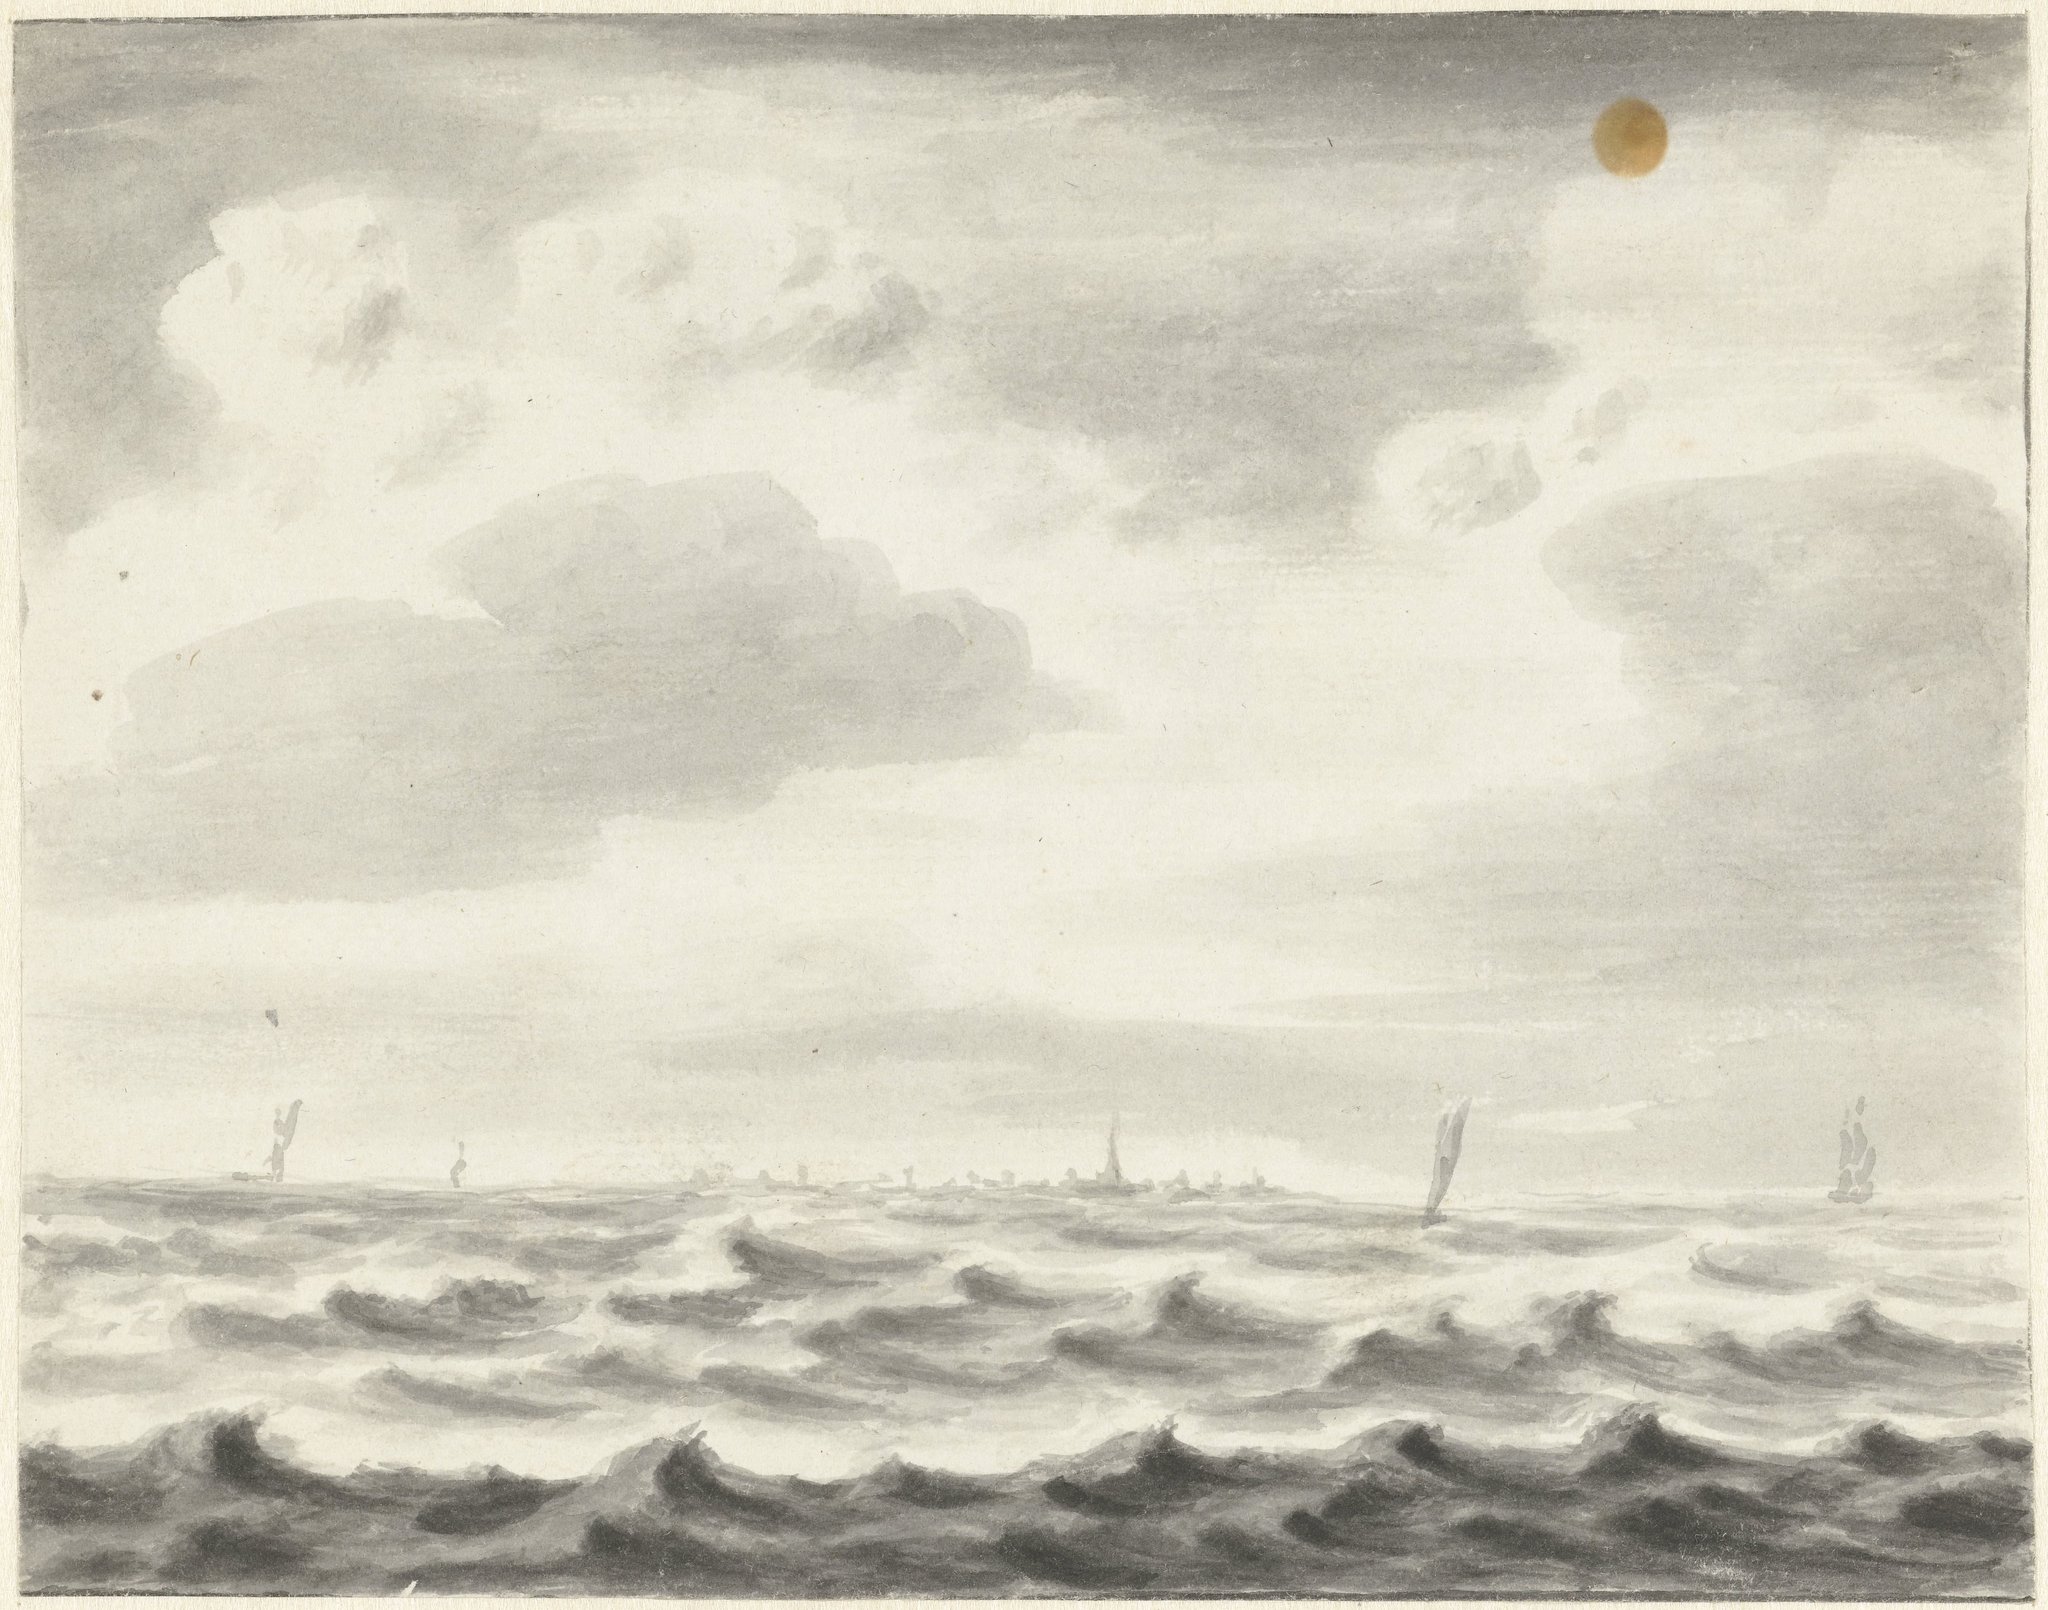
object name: drawing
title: Zeegezicht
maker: pieter idserts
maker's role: draughtsman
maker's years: 1698-1781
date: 1708-1781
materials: paper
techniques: brush